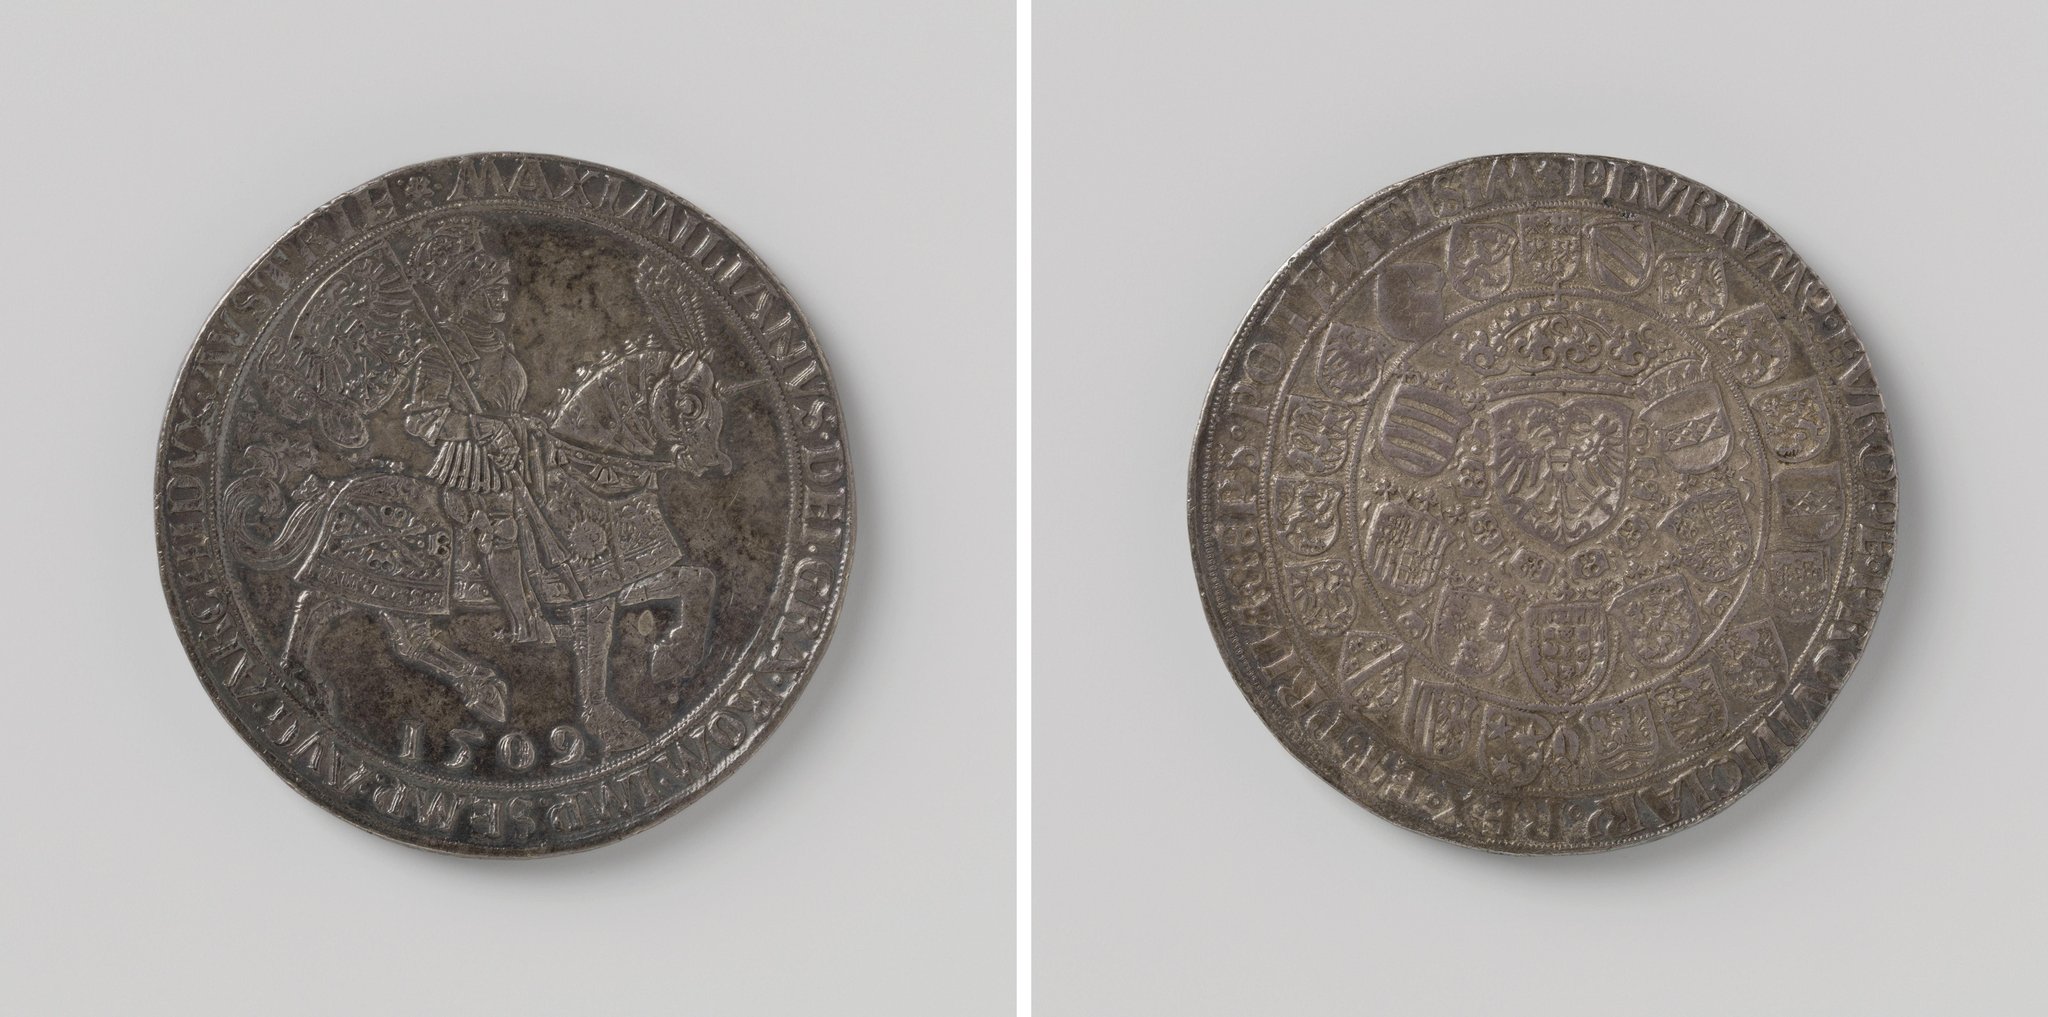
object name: history medal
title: Maximiliaan I, Duits keizer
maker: Anonymous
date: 1509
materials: silver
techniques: striking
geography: hall am inn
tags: maximilian i (holy roman emperor)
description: Zilveren penning. Voorzijde: ruiter in harnas met keizerlijk vaandel, boven jaartal, binnen omschrift. Keerzijde: gekroond wapenschild omhangen met Gulden Vlies binnen rand van zeven wapens, binnen rand van negentien wapens binnen omschrift